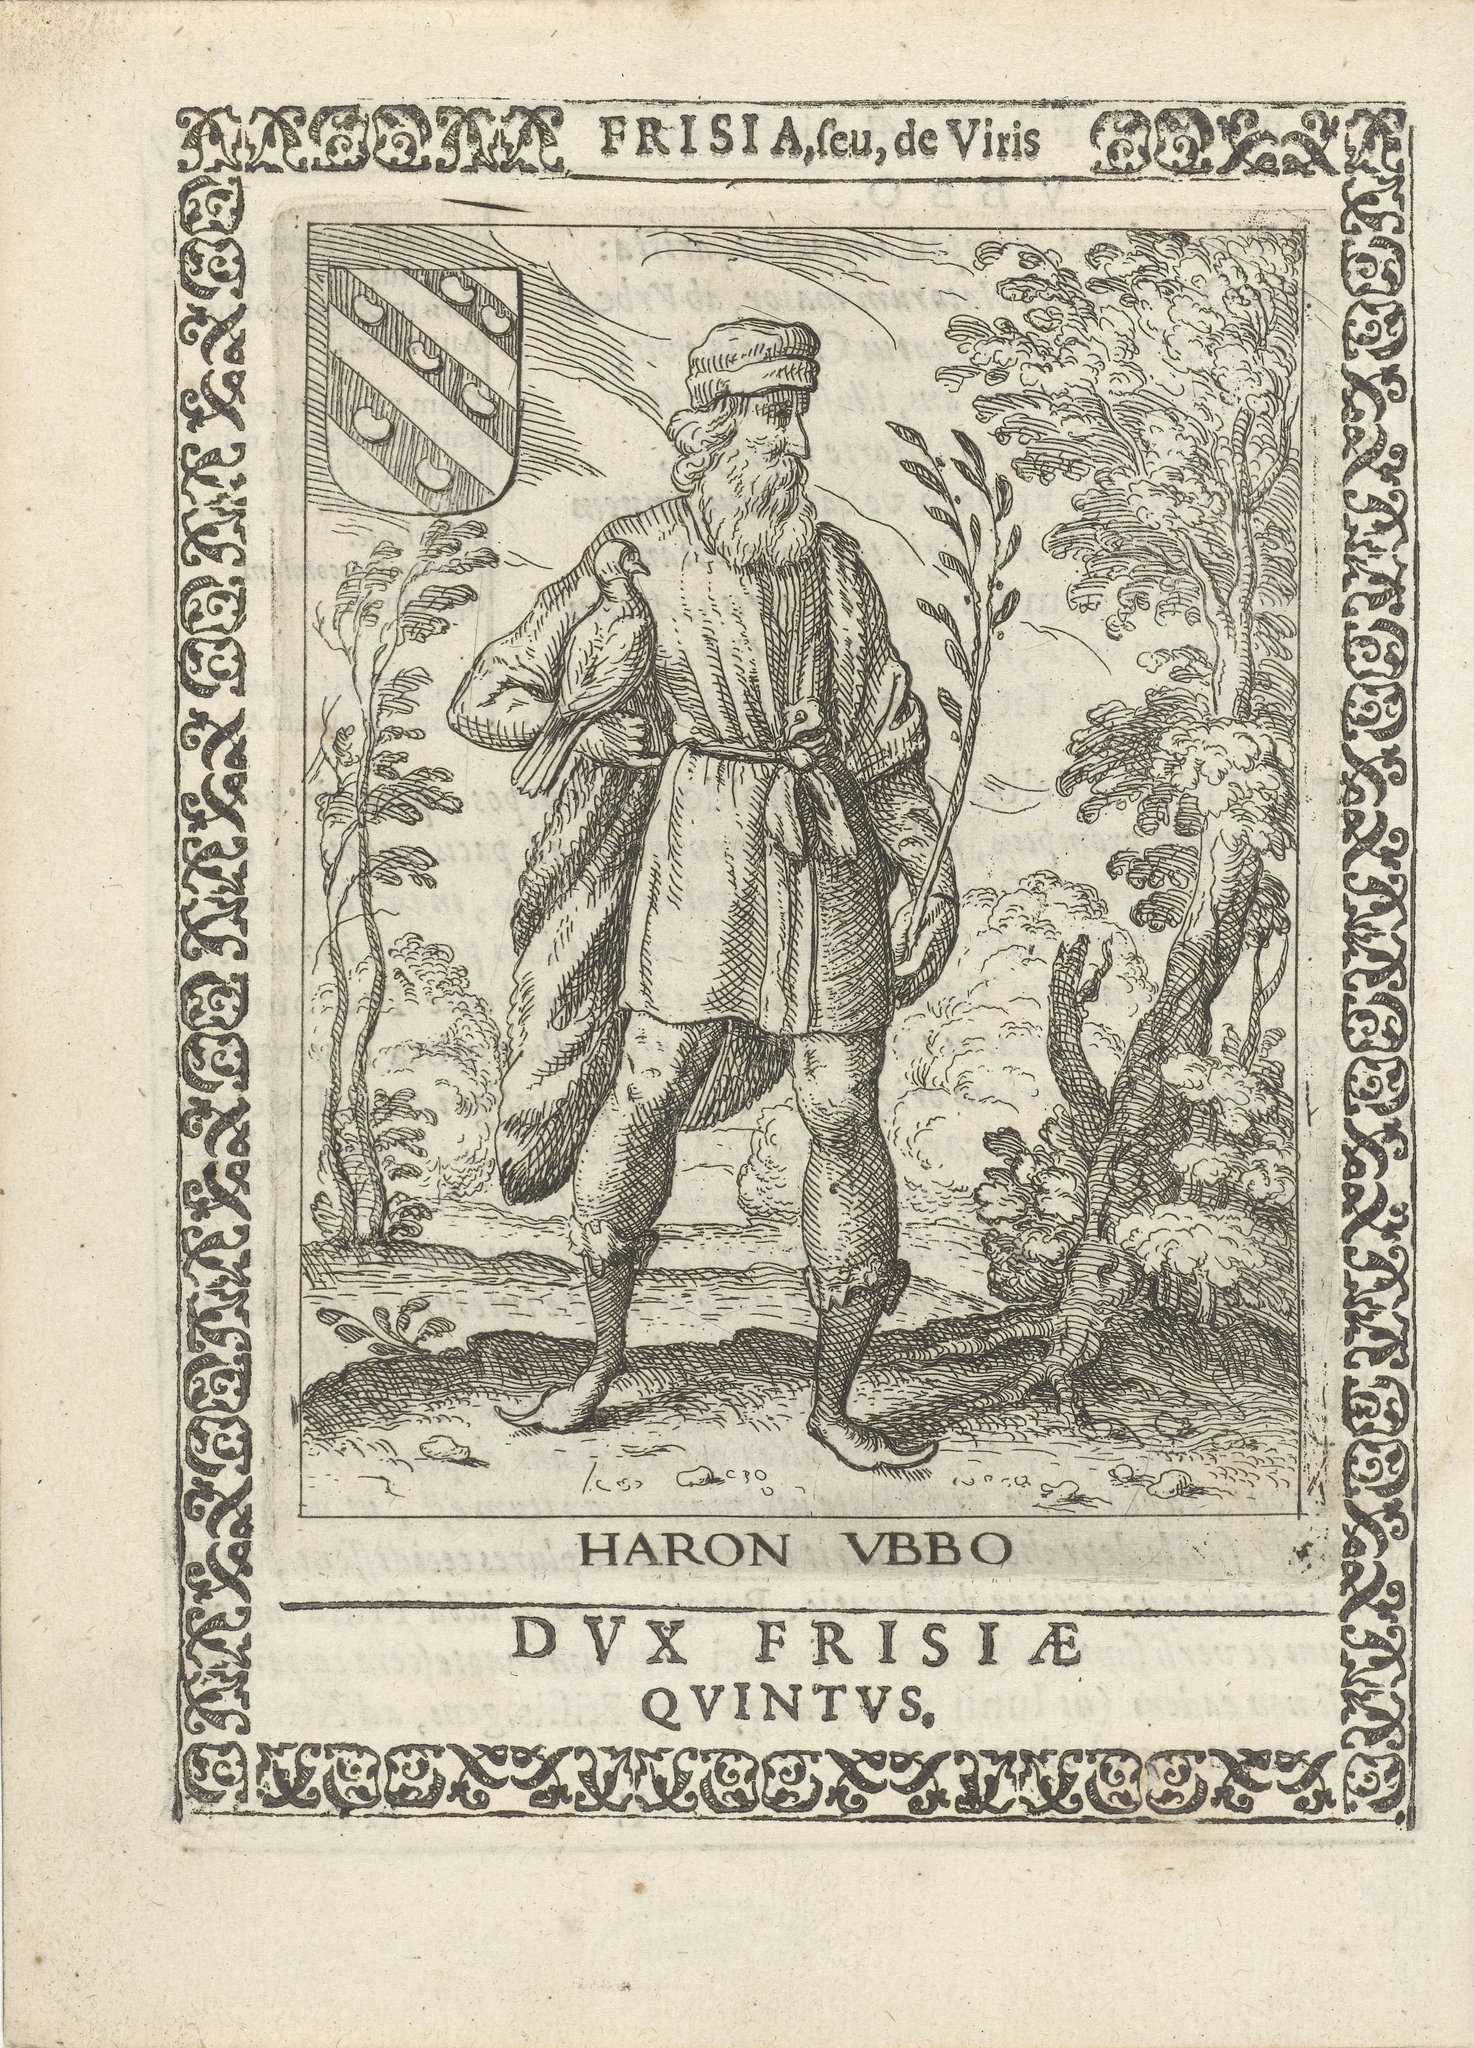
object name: book illustration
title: Koningen en Potestaten van Friesland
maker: pieter feddes van harlingen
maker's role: painter, print maker, publisher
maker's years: 1586-1623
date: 1618-1620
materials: paper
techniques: etching, letterpress printing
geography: friesland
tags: ruler, sovereign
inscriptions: collector's mark: Lugt 2228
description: Haron Ubbo, vijfde hertog der Friezen. Staande ten voeten uit, een tak in de hand. In een ornamentale omlijsting. Illustratie, met tekst op achterzijde, afkomstig uit het boek: Frisia seu de viris rebusque Frisiae illustribus libri duo.